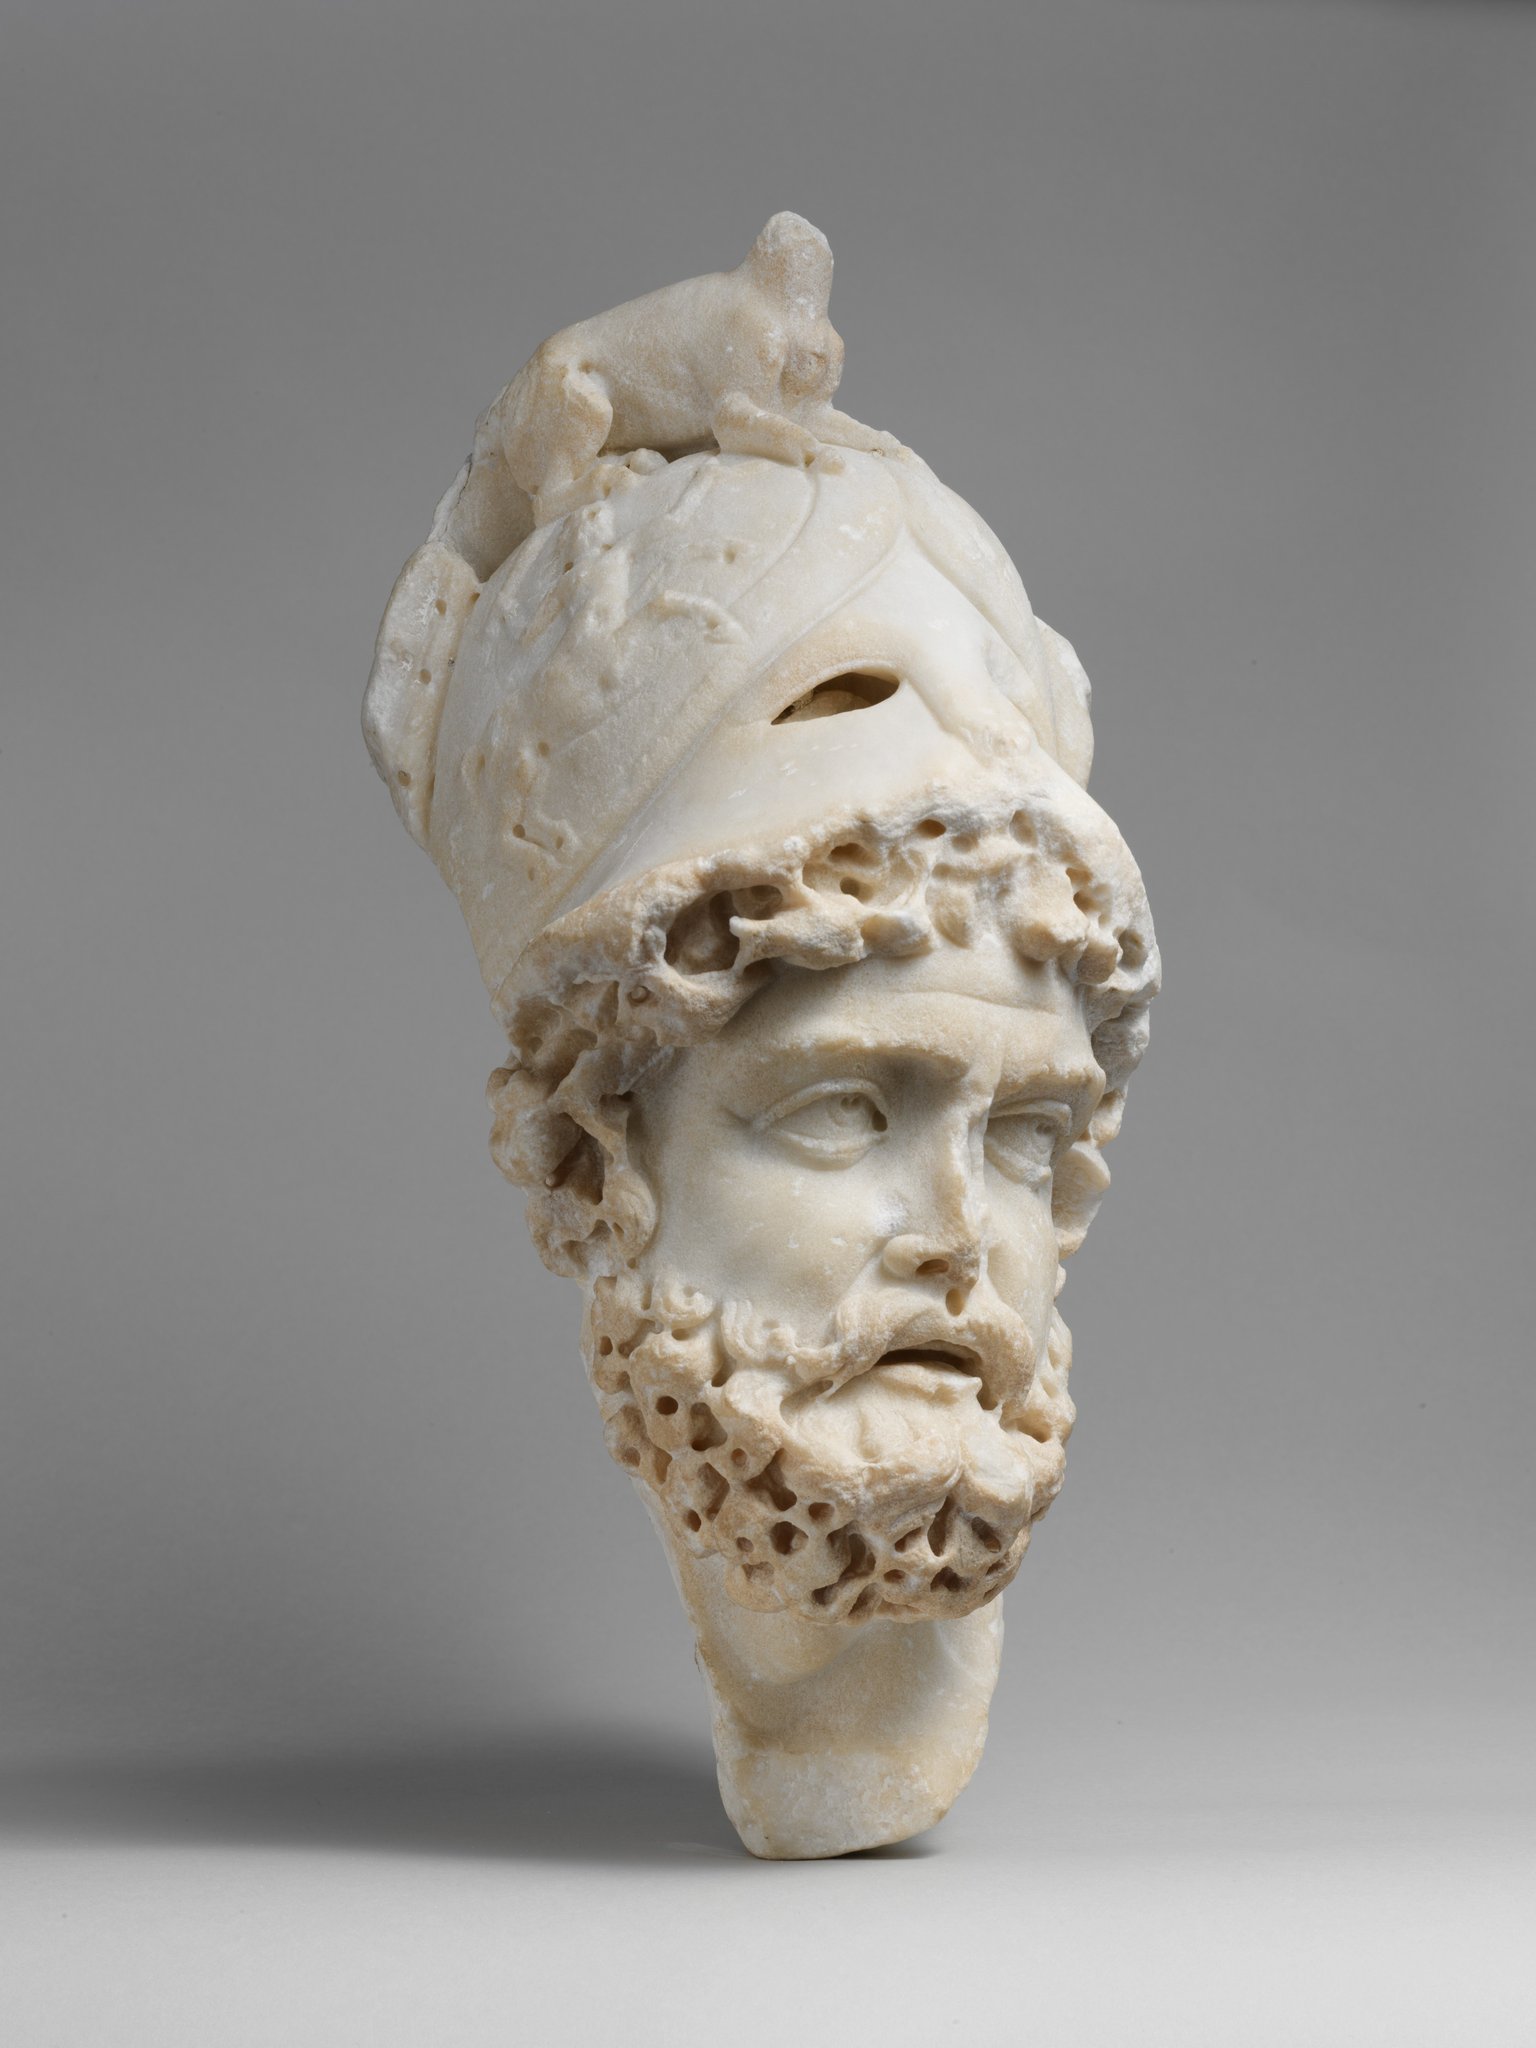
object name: relief fragment with the head of mar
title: Marble relief fragment with the head of Mars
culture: roman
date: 201-233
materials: marble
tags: heads,mars